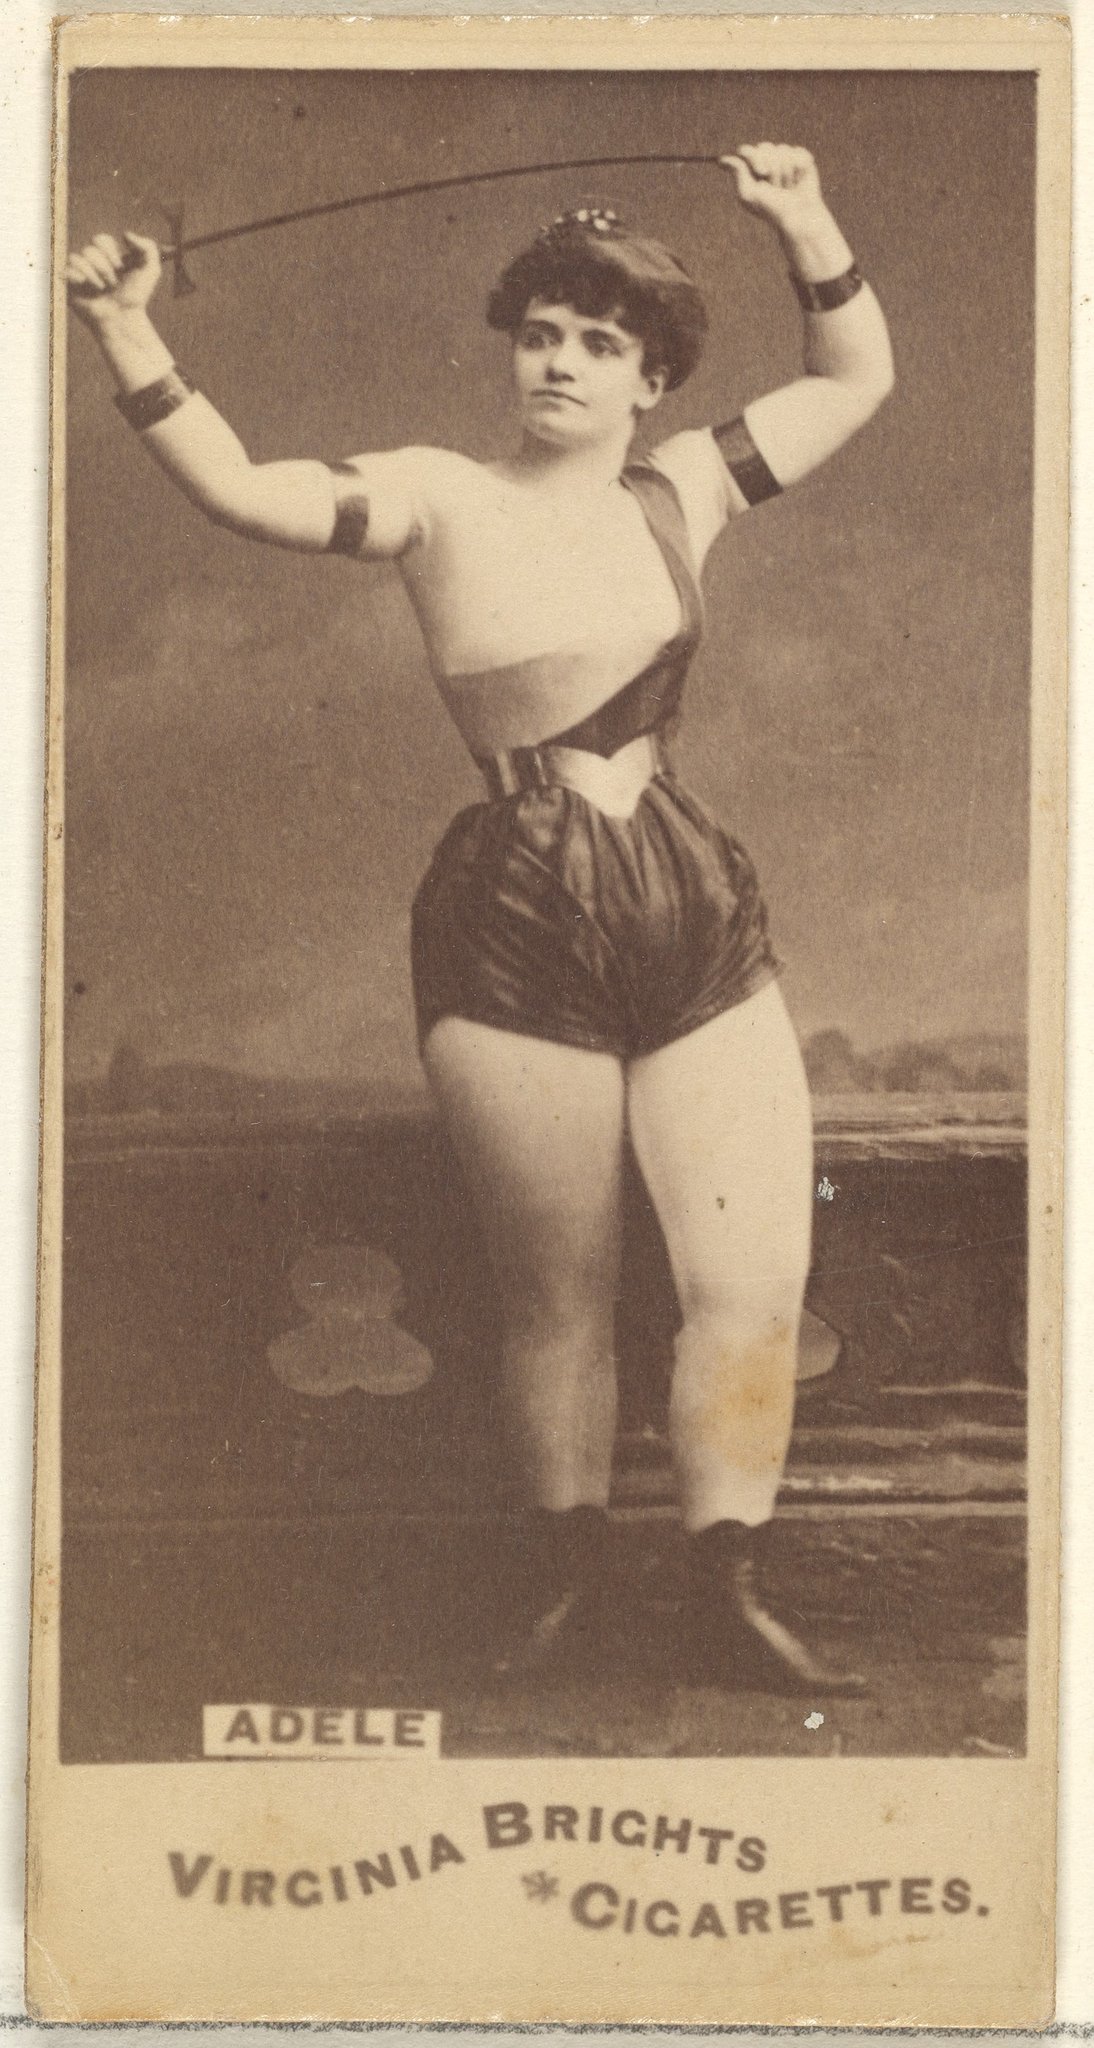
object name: photograph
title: Adele, from the Actors and Actresses series (N45, Type 1) for Virginia Brights Cigarettes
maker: allen & ginter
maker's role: publisher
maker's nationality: american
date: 1888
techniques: albumen silver print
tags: portraits,women,actresses